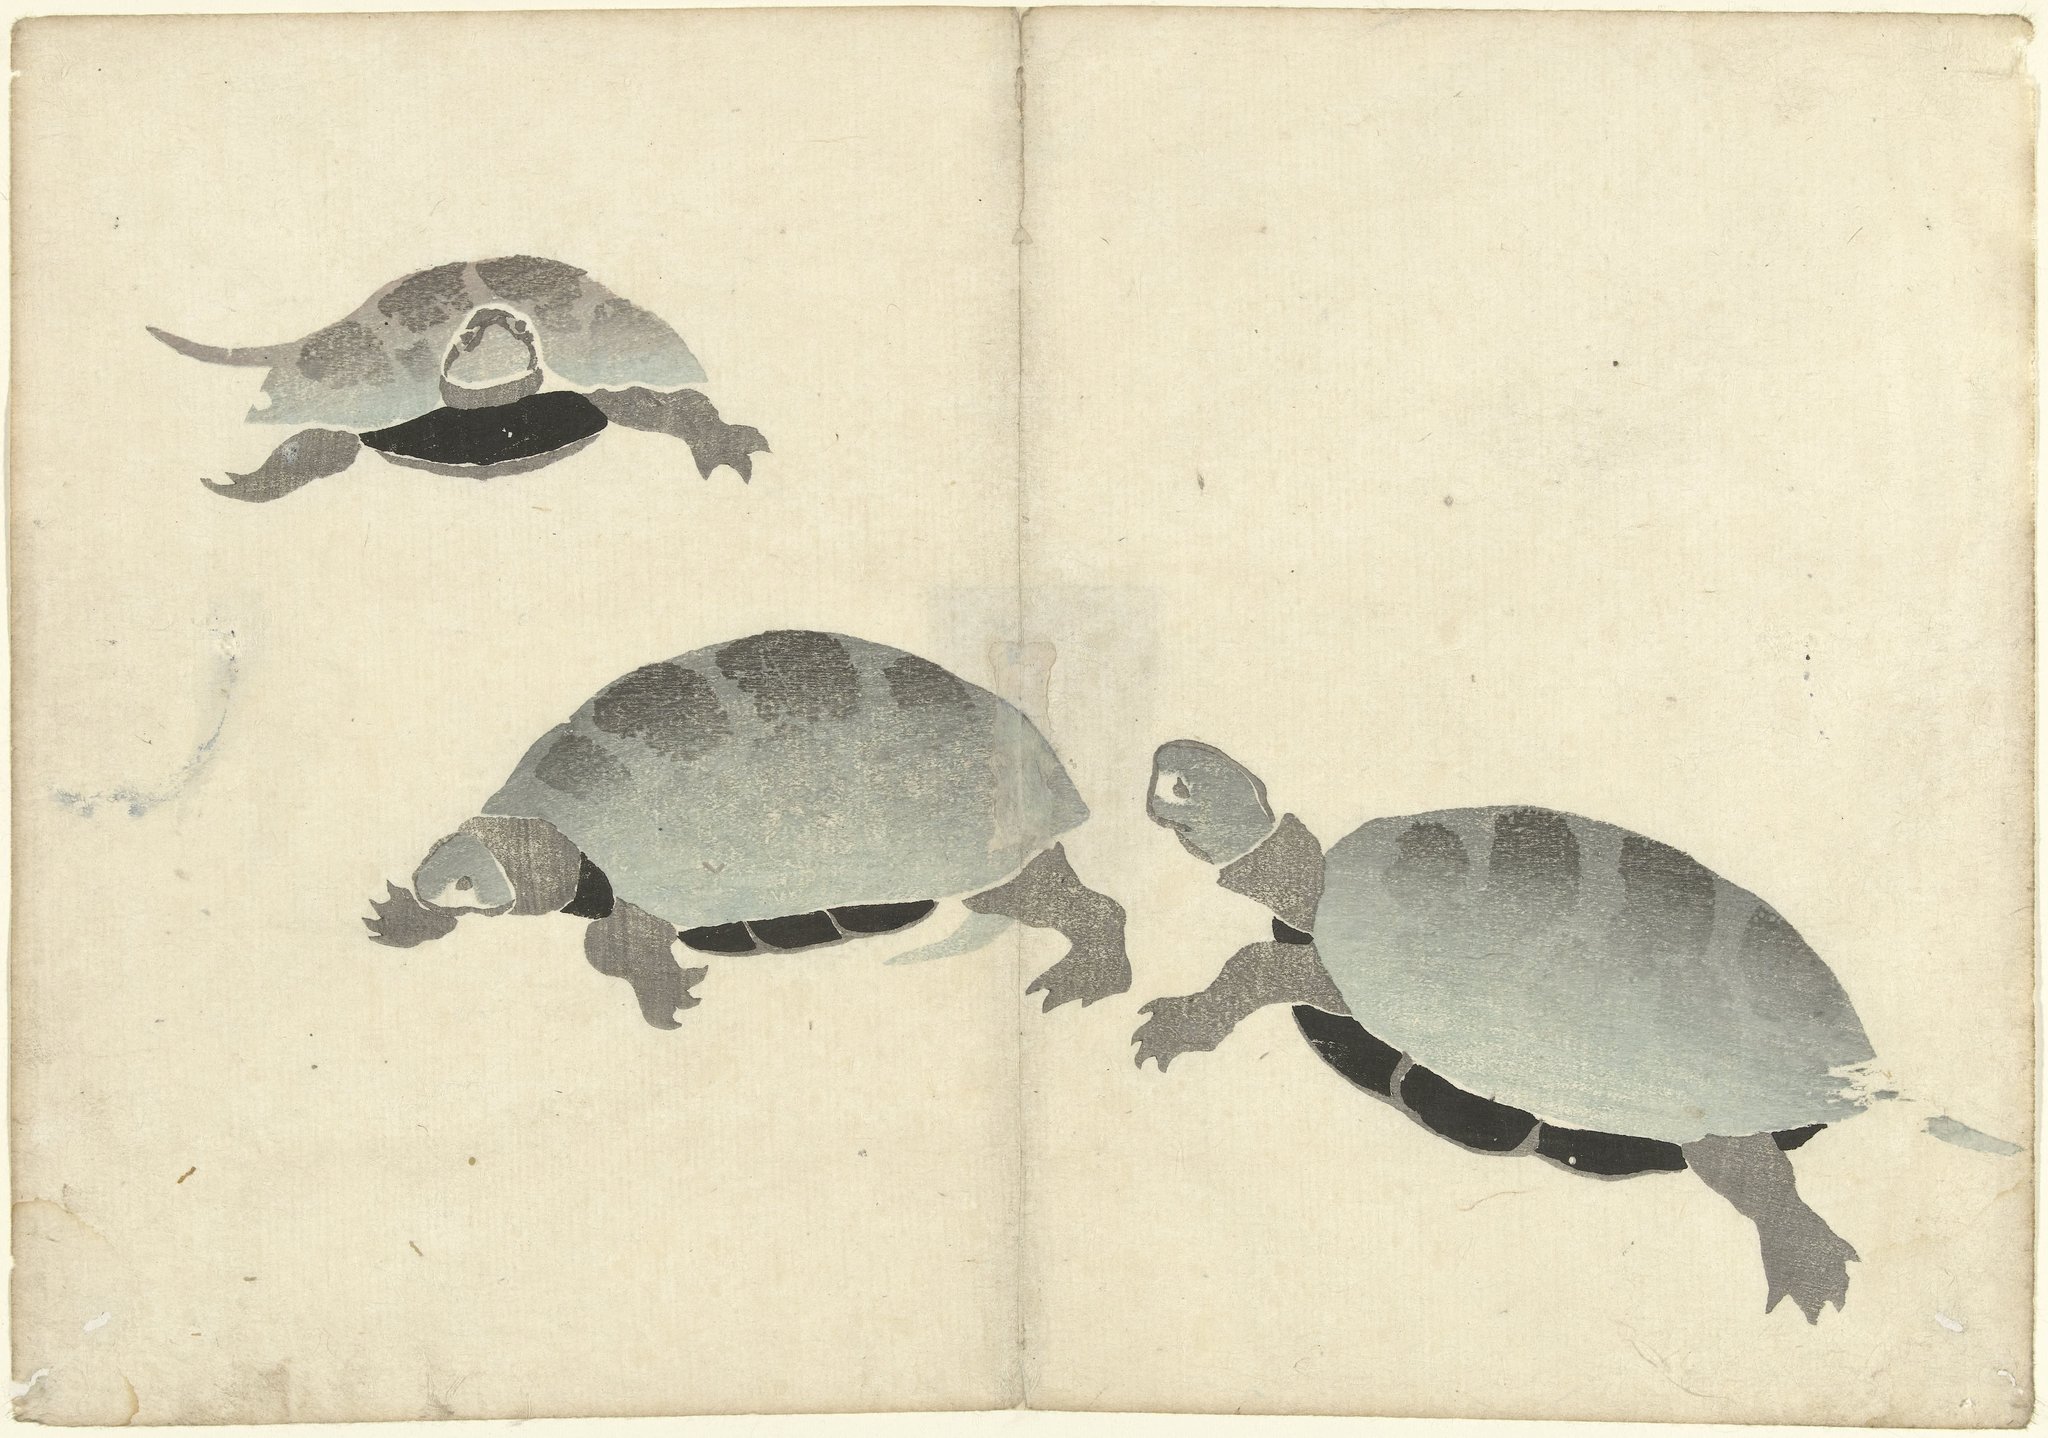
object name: print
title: Drie schildpadden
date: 1826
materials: paper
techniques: woodcut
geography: edo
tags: tortoises, turtles